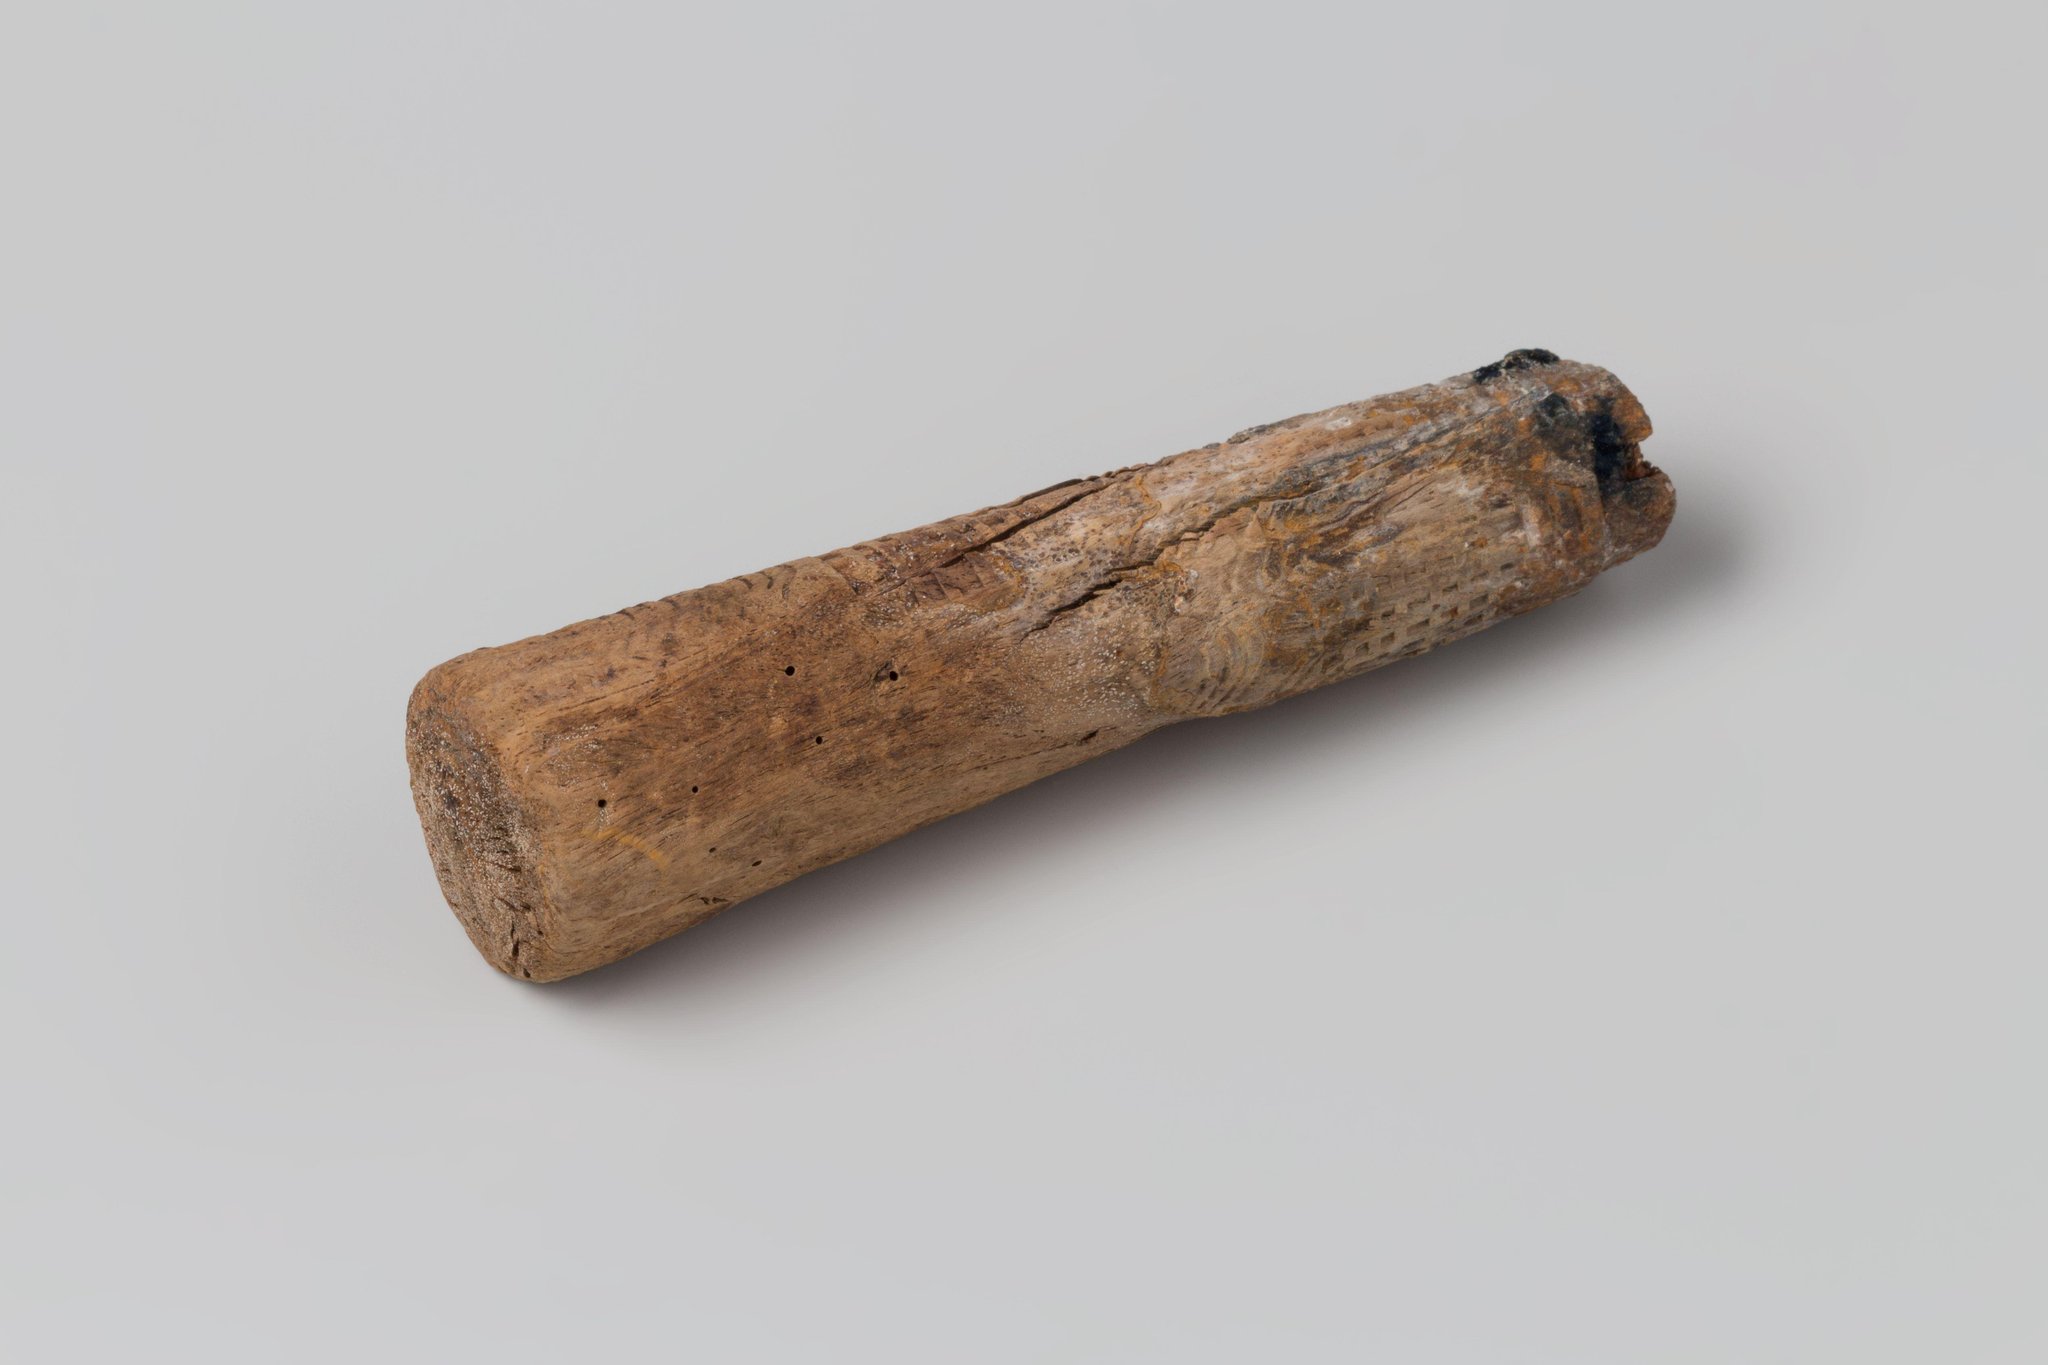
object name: knife handle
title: Messenheft uit het wrak van de Oost-Indiëvaarder Hollandia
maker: Anonymous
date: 1700-1743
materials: wood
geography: netherlands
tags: verenigde oostindische compagnie, hollandia (schip), annet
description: Knife, handle, cylindrical: tapering; id. NG 1979-403H.